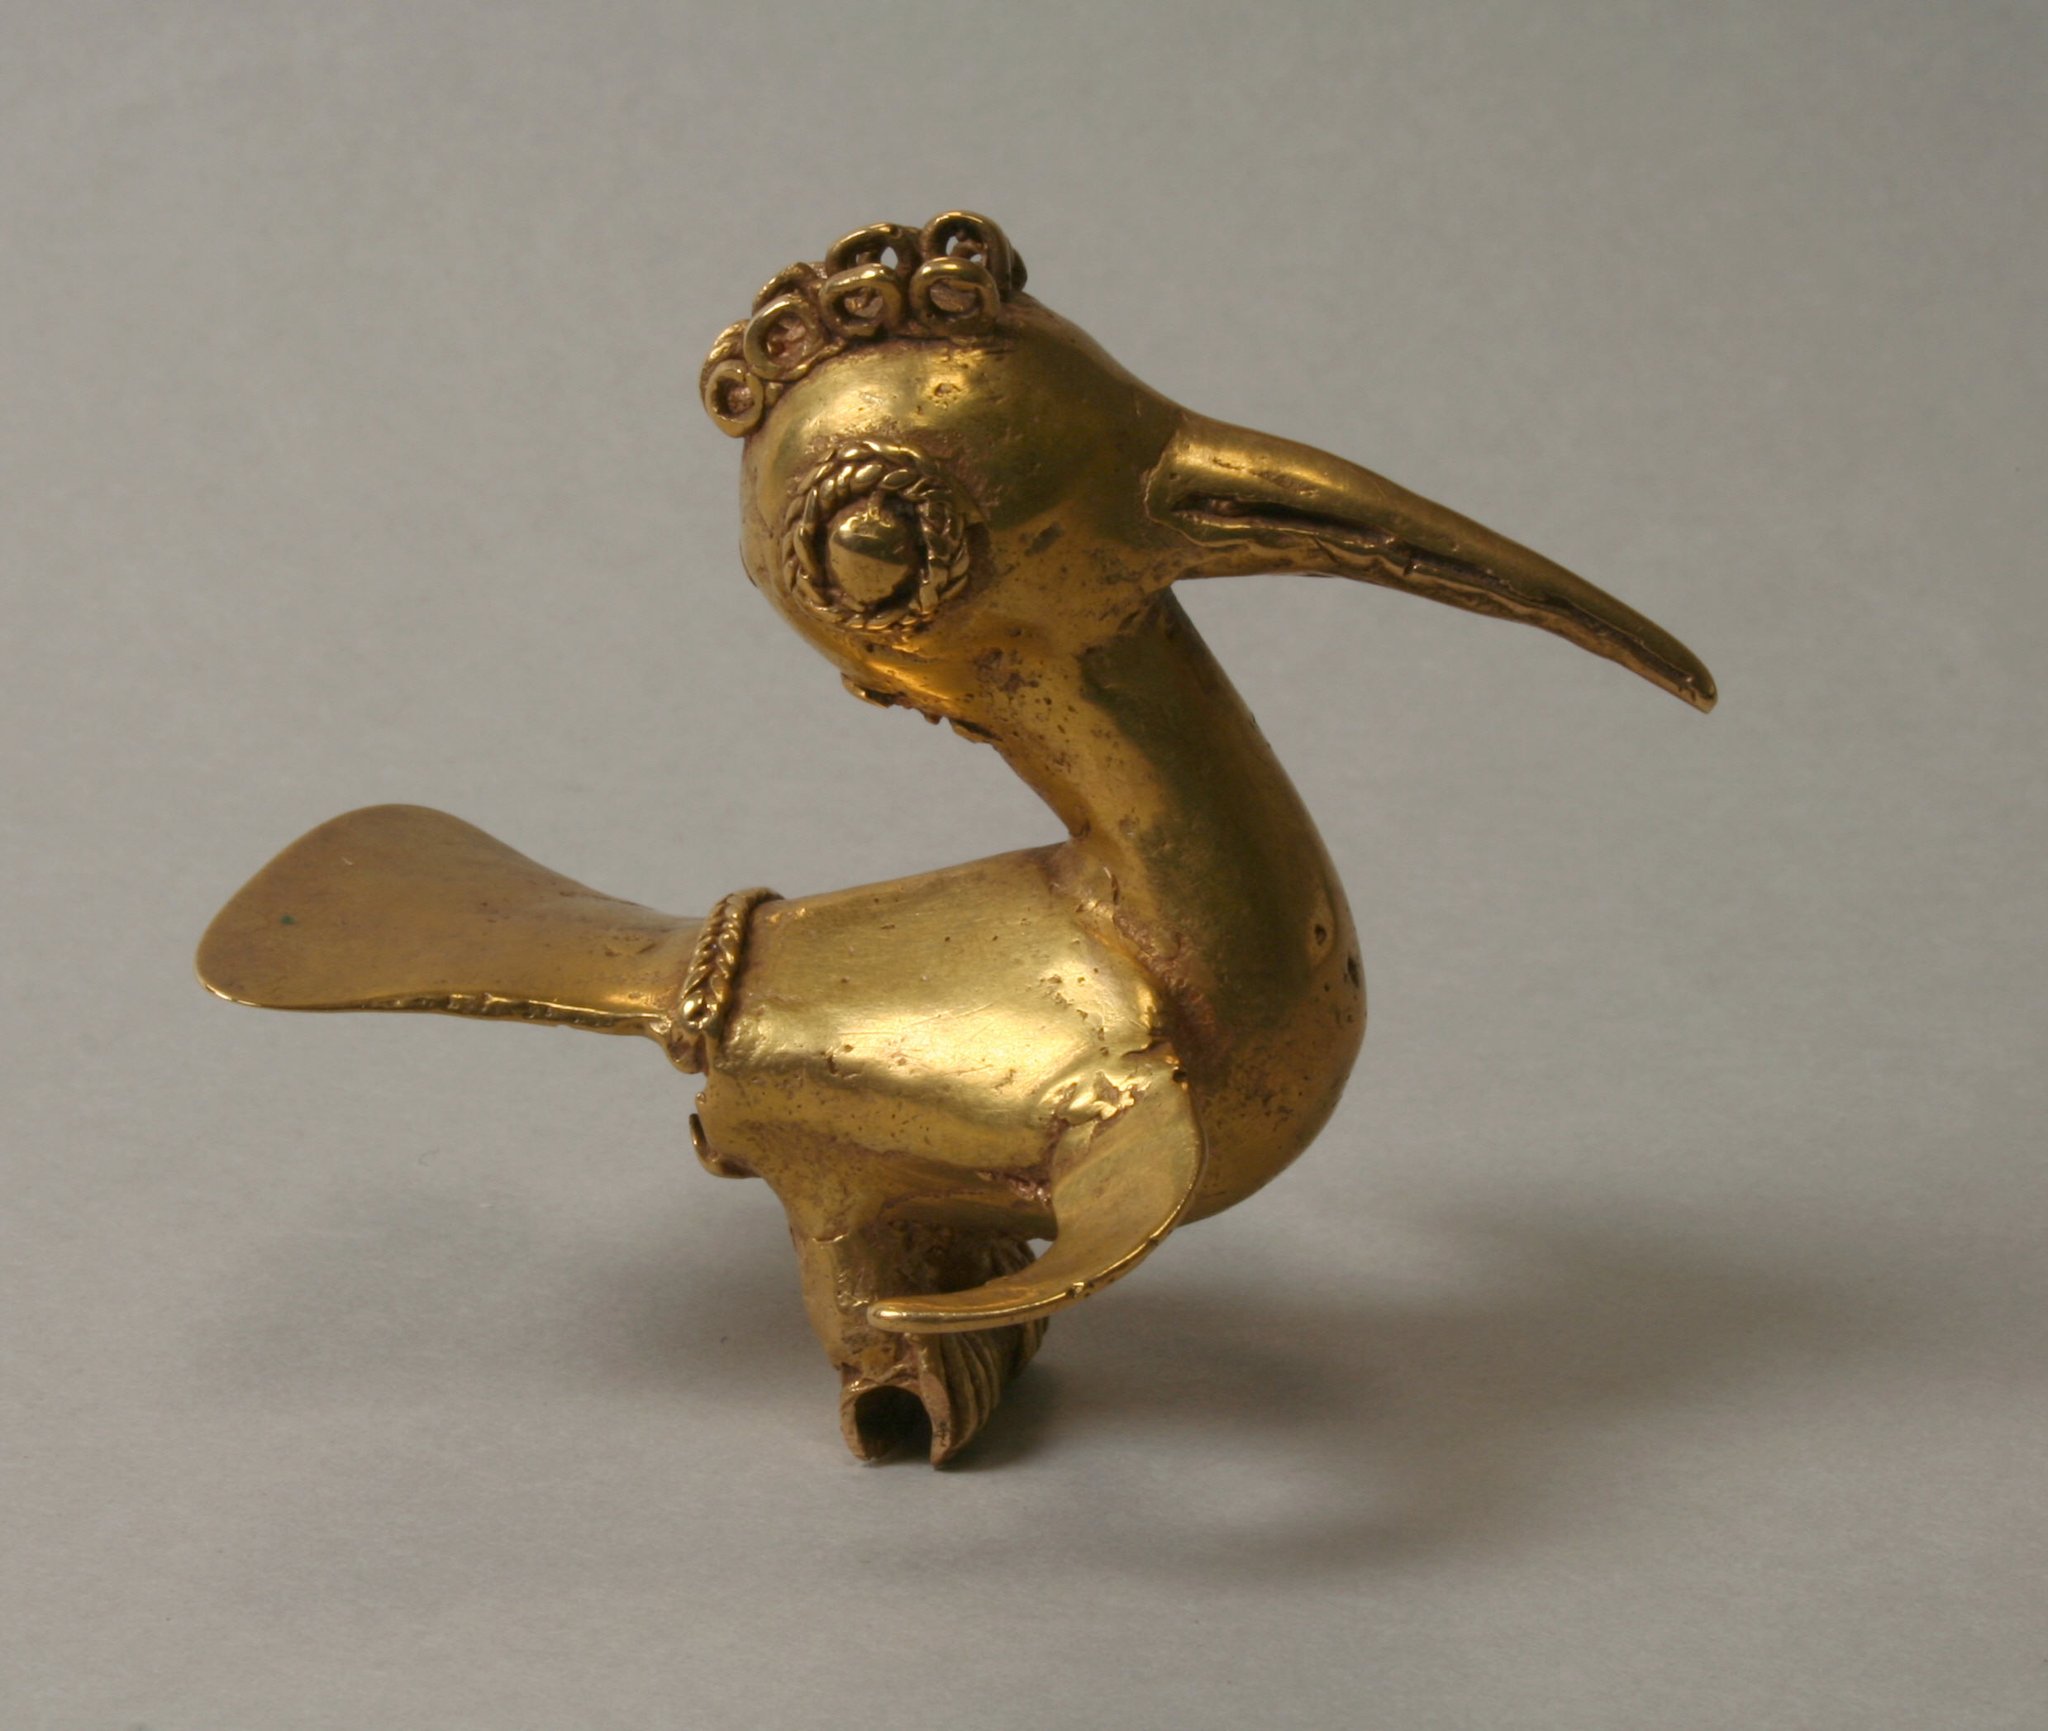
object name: finial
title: Bird Finial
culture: sinu or zenu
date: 401-1000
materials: gold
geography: colombia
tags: birds